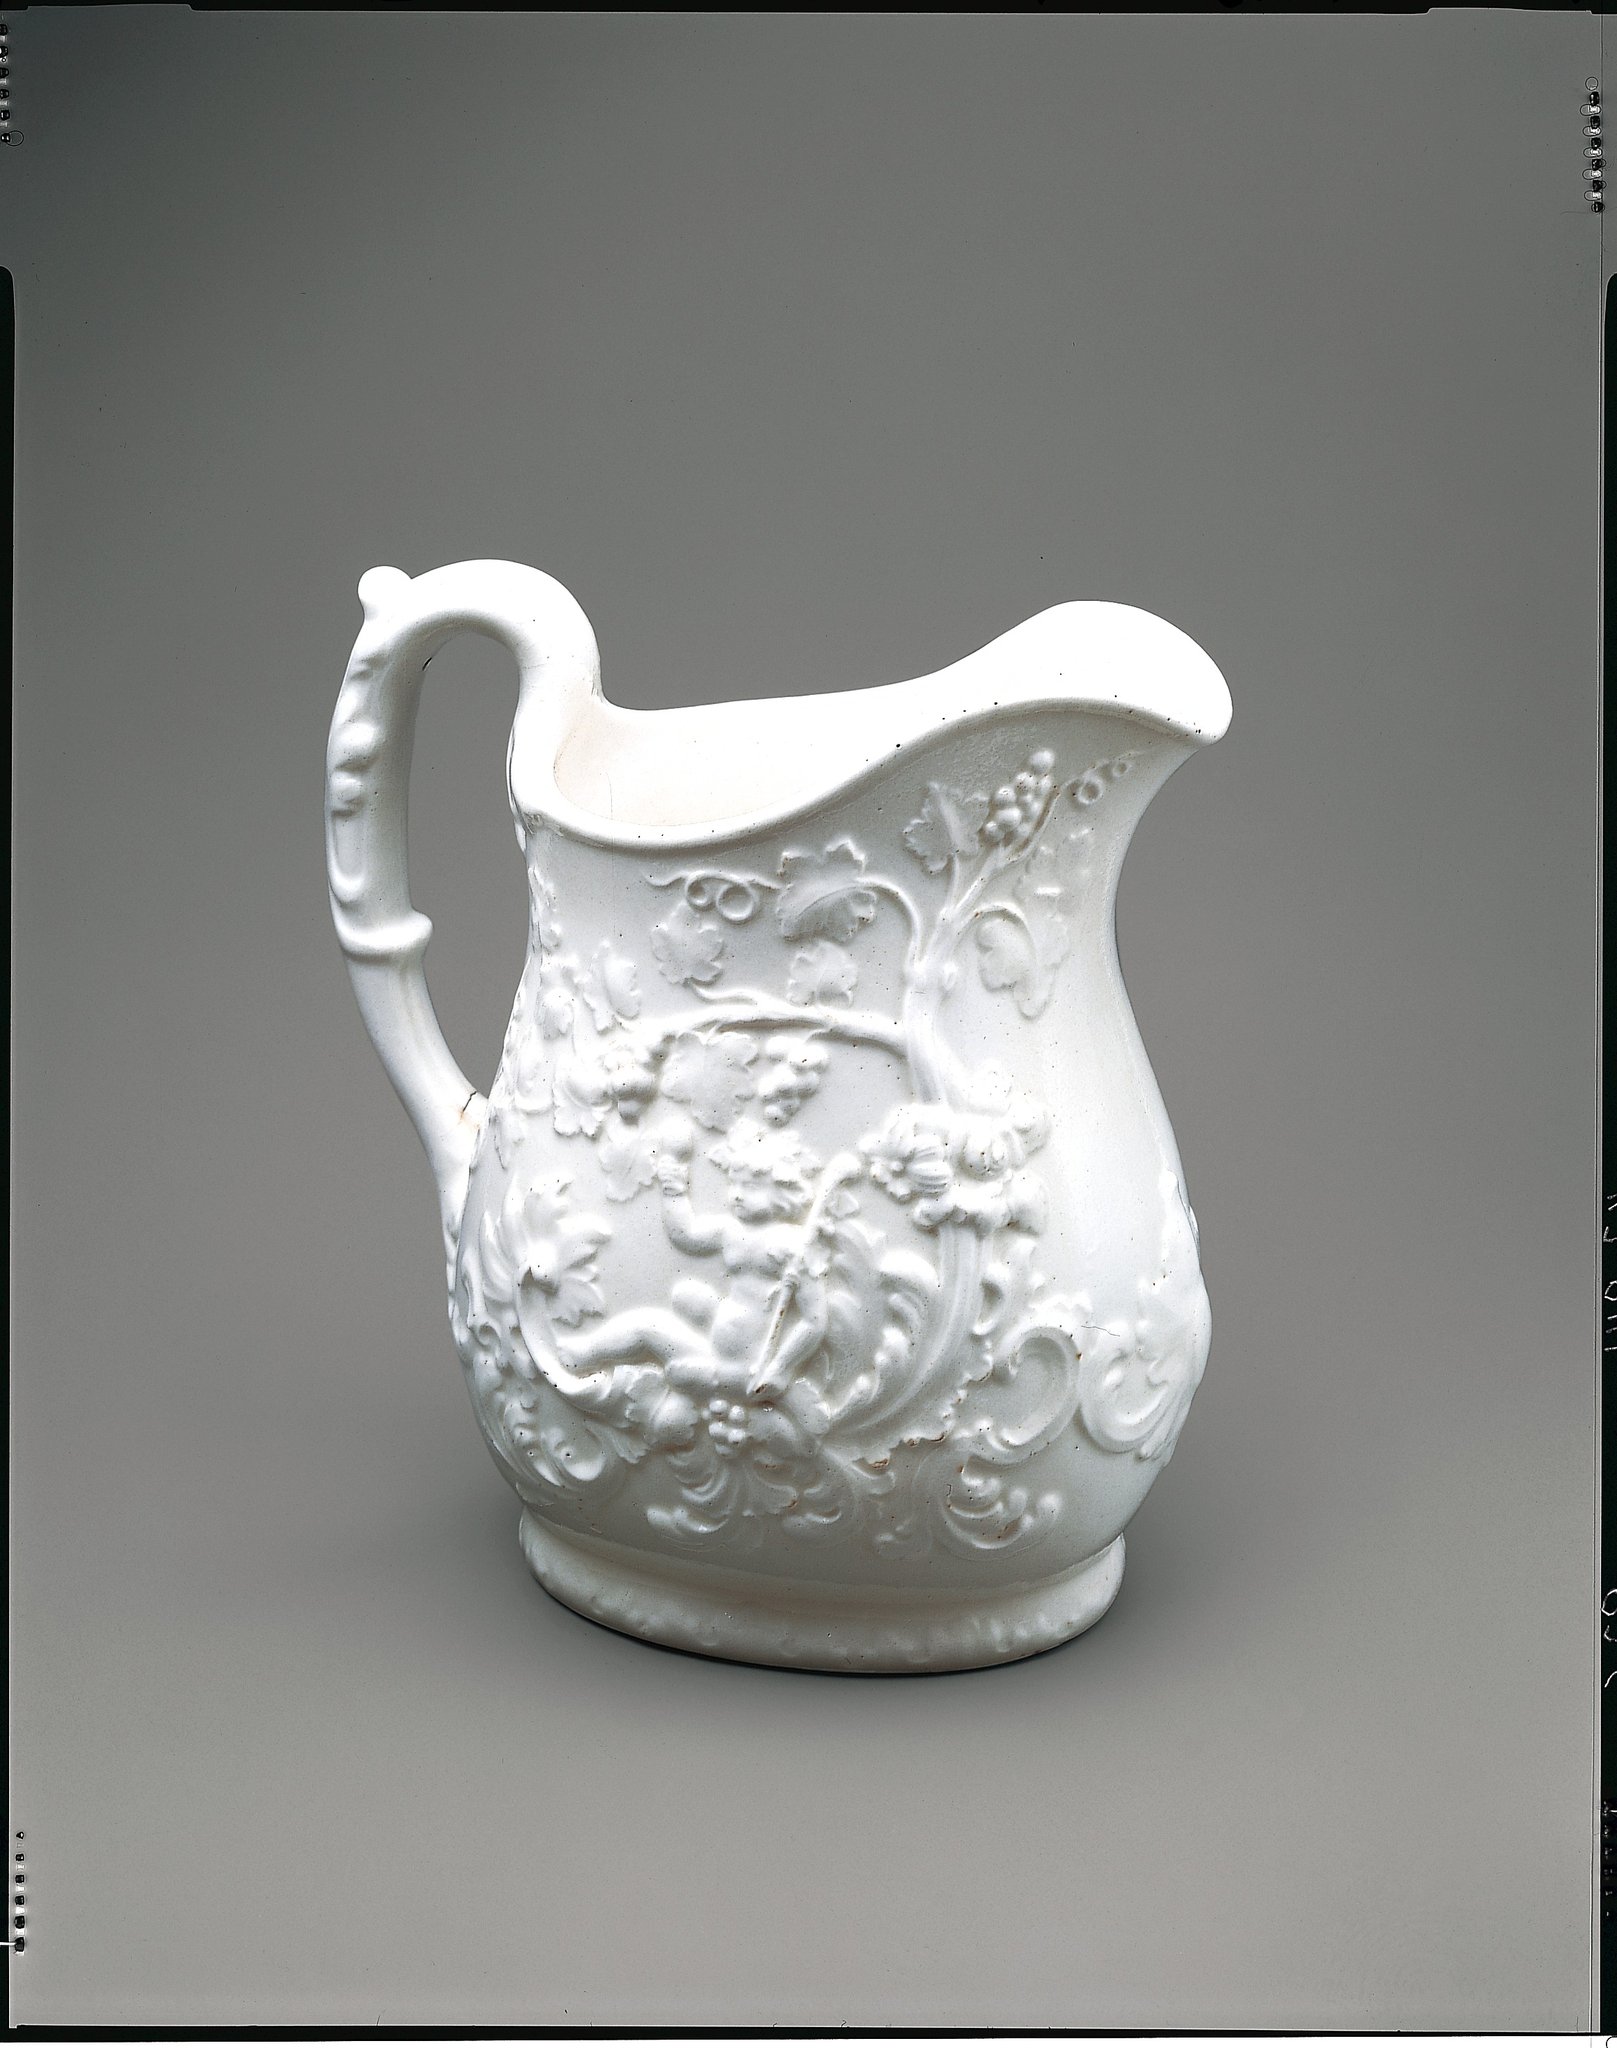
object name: pitcher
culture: american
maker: william boch and brothers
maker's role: maker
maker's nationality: american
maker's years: 1844-1862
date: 1855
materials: porcelain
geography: united states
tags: grapes,putti